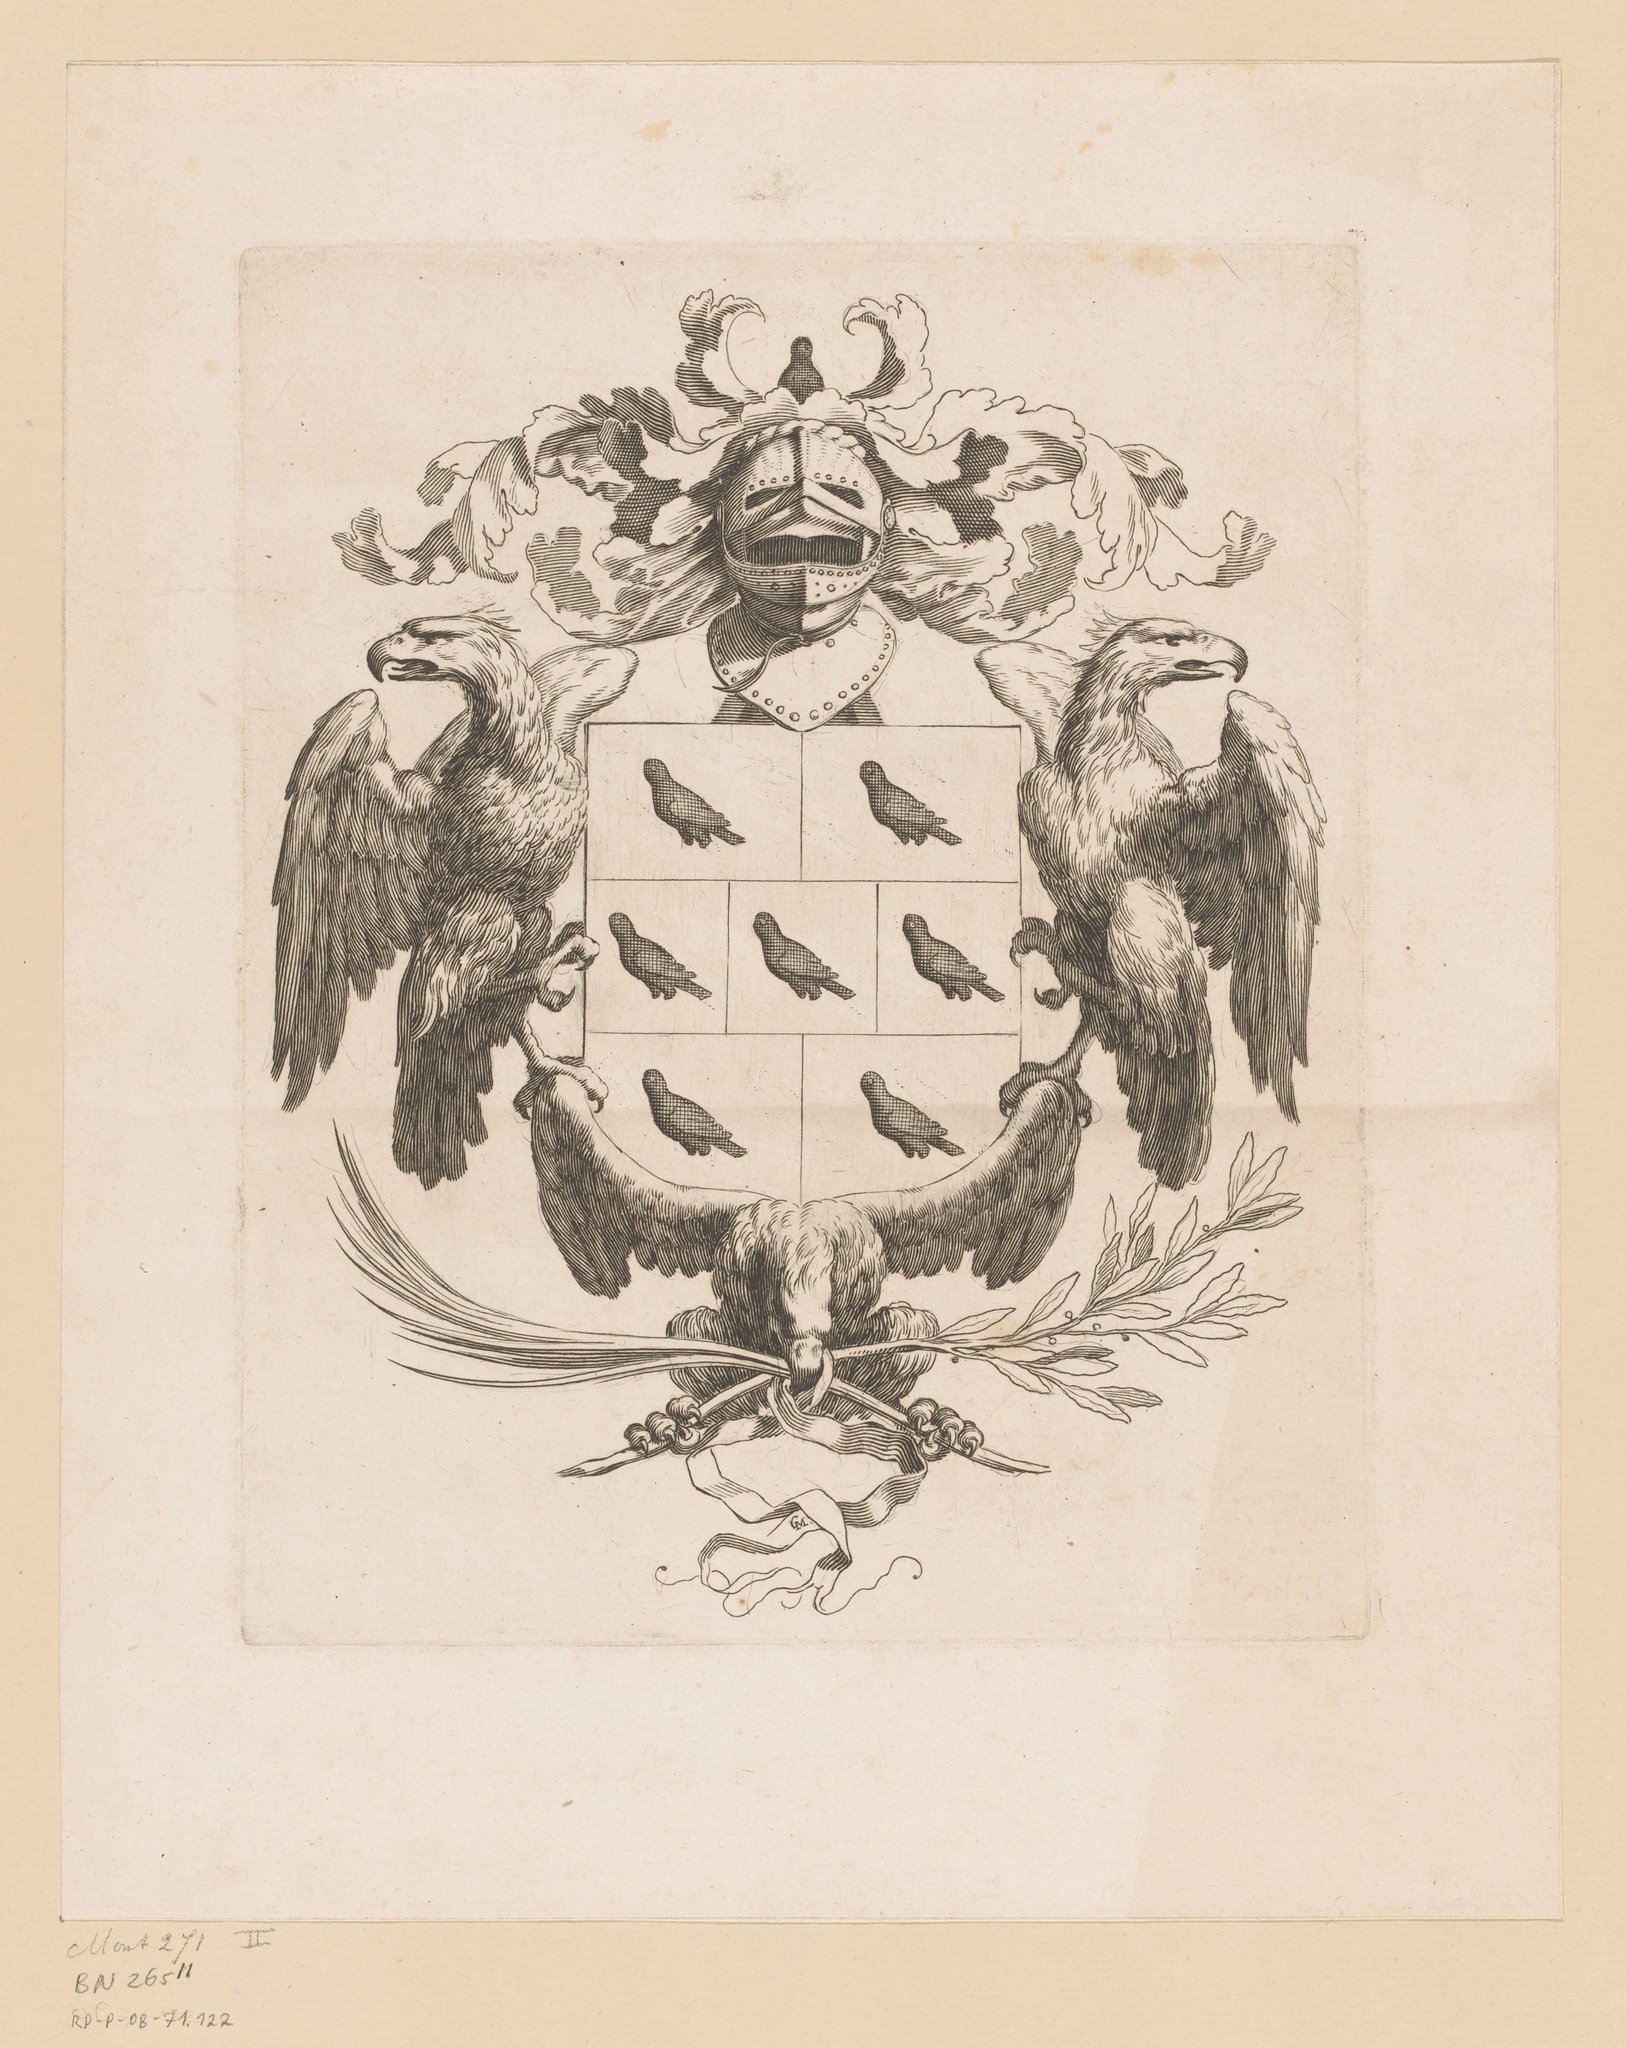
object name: print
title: Wapen van de familie Marillac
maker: claude mellan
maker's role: draughtsman, print maker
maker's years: 1598-1688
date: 1608-1688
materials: paper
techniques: engraving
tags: armorial bearing, heraldry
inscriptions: collector's mark: Lugt 240, watermark